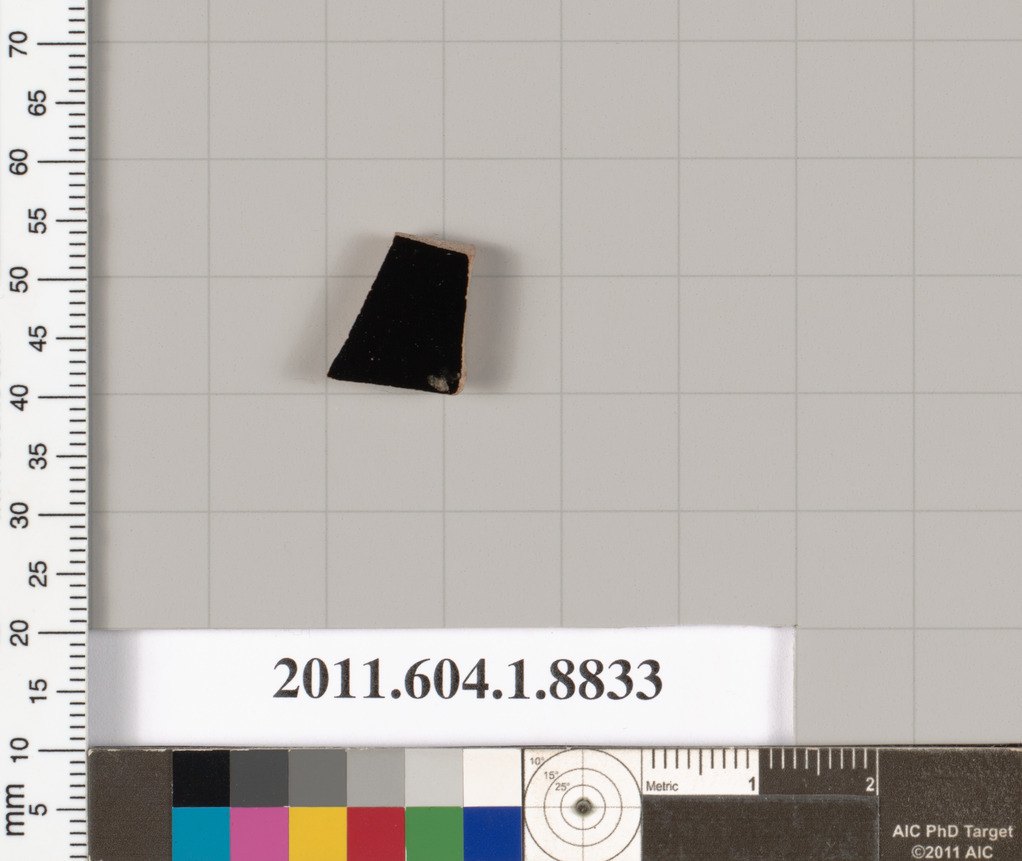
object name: kylix fragment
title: Terracotta fragment of a kylix (drinking cup)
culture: greek, attic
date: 500-470 BCE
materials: terracotta